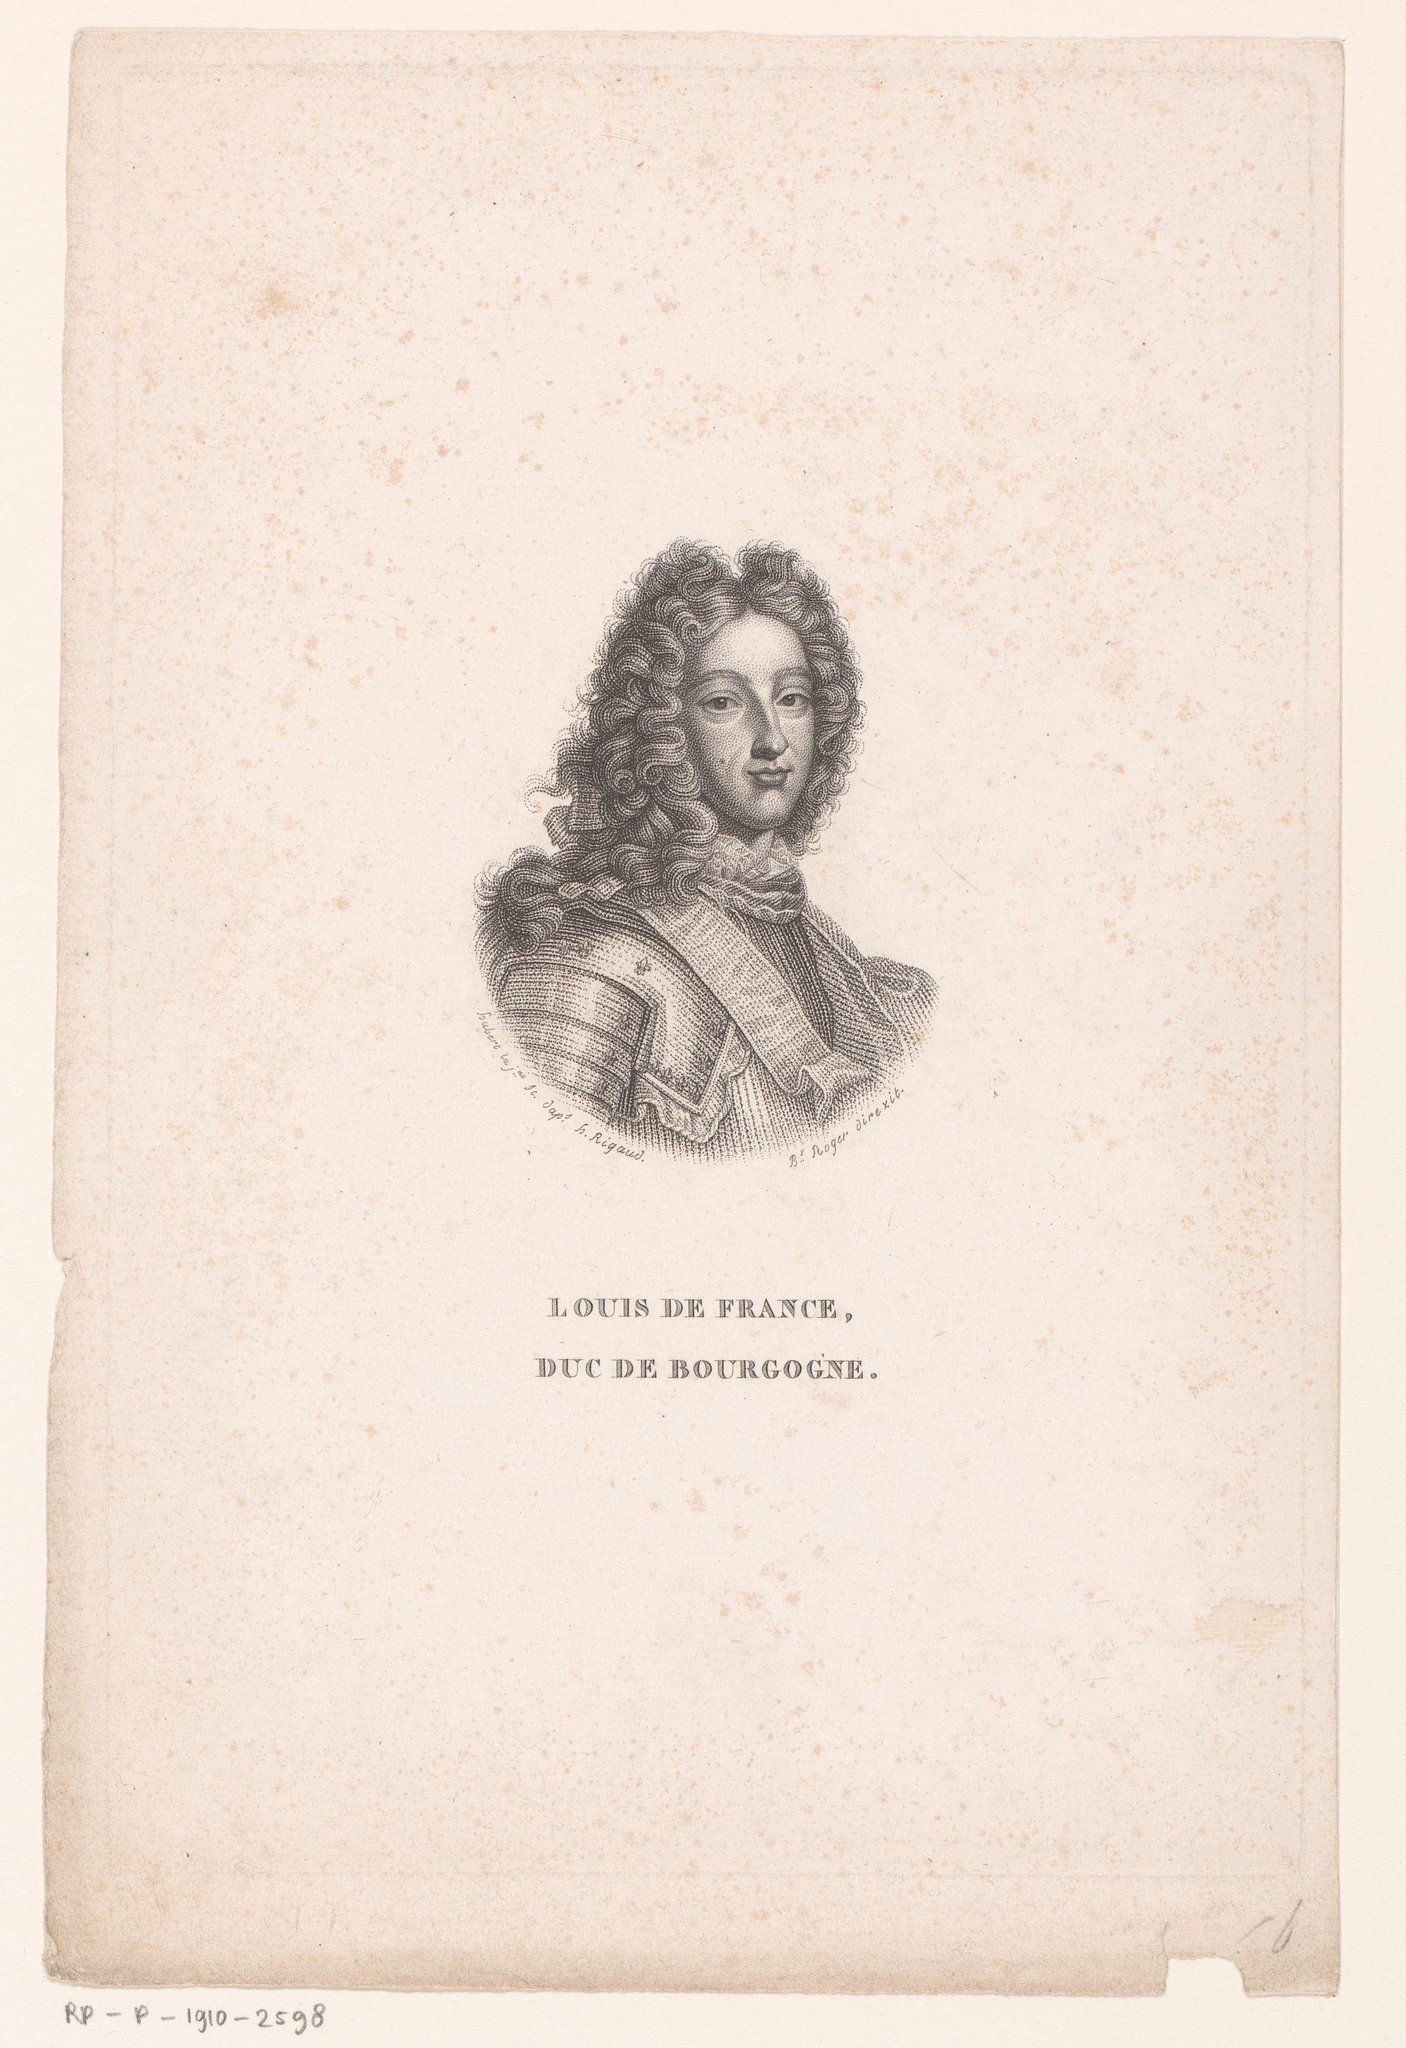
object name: print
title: Portret van Lodewijk van Frankrijk, hertog van Bourgondië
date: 1811-1841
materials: paper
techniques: engraving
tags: lodewijk van frankrijk (hertog van bourgondië), historical persons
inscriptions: collector's mark: Lugt 2228